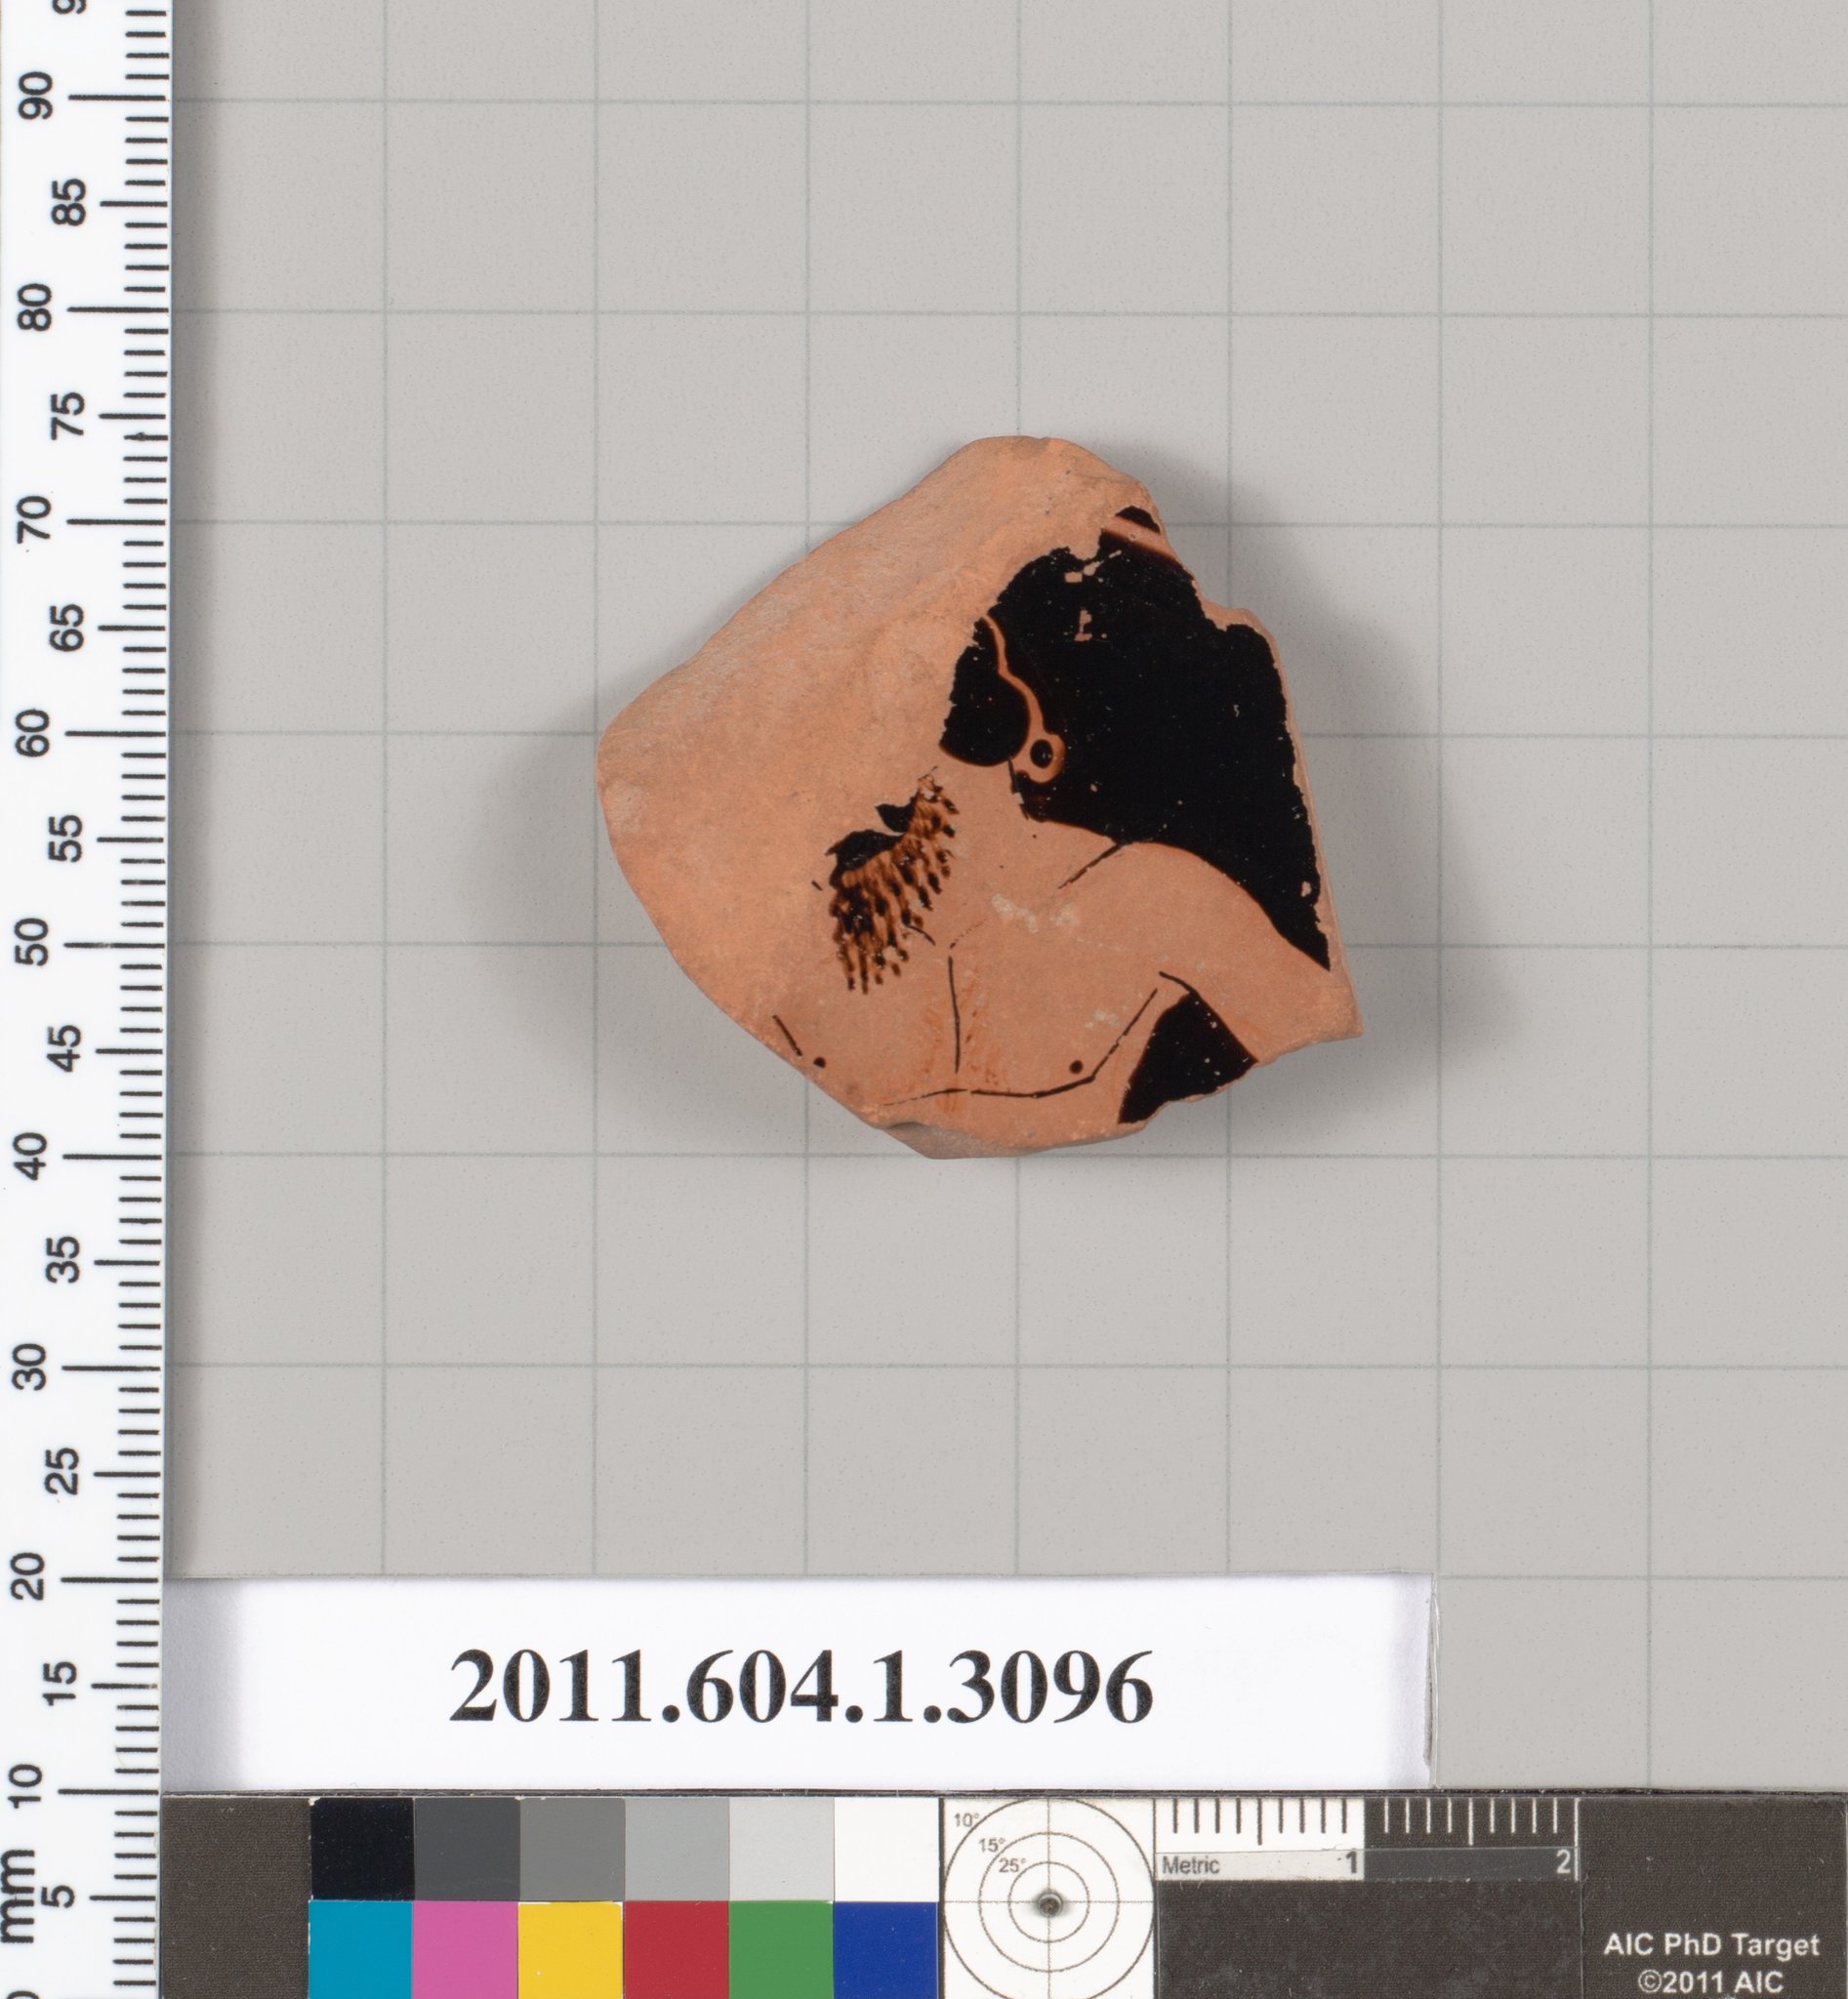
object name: kylix fragment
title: Terracotta fragment of a kylix (drinking cup)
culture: greek, attic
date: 475-451 BCE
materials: terracotta